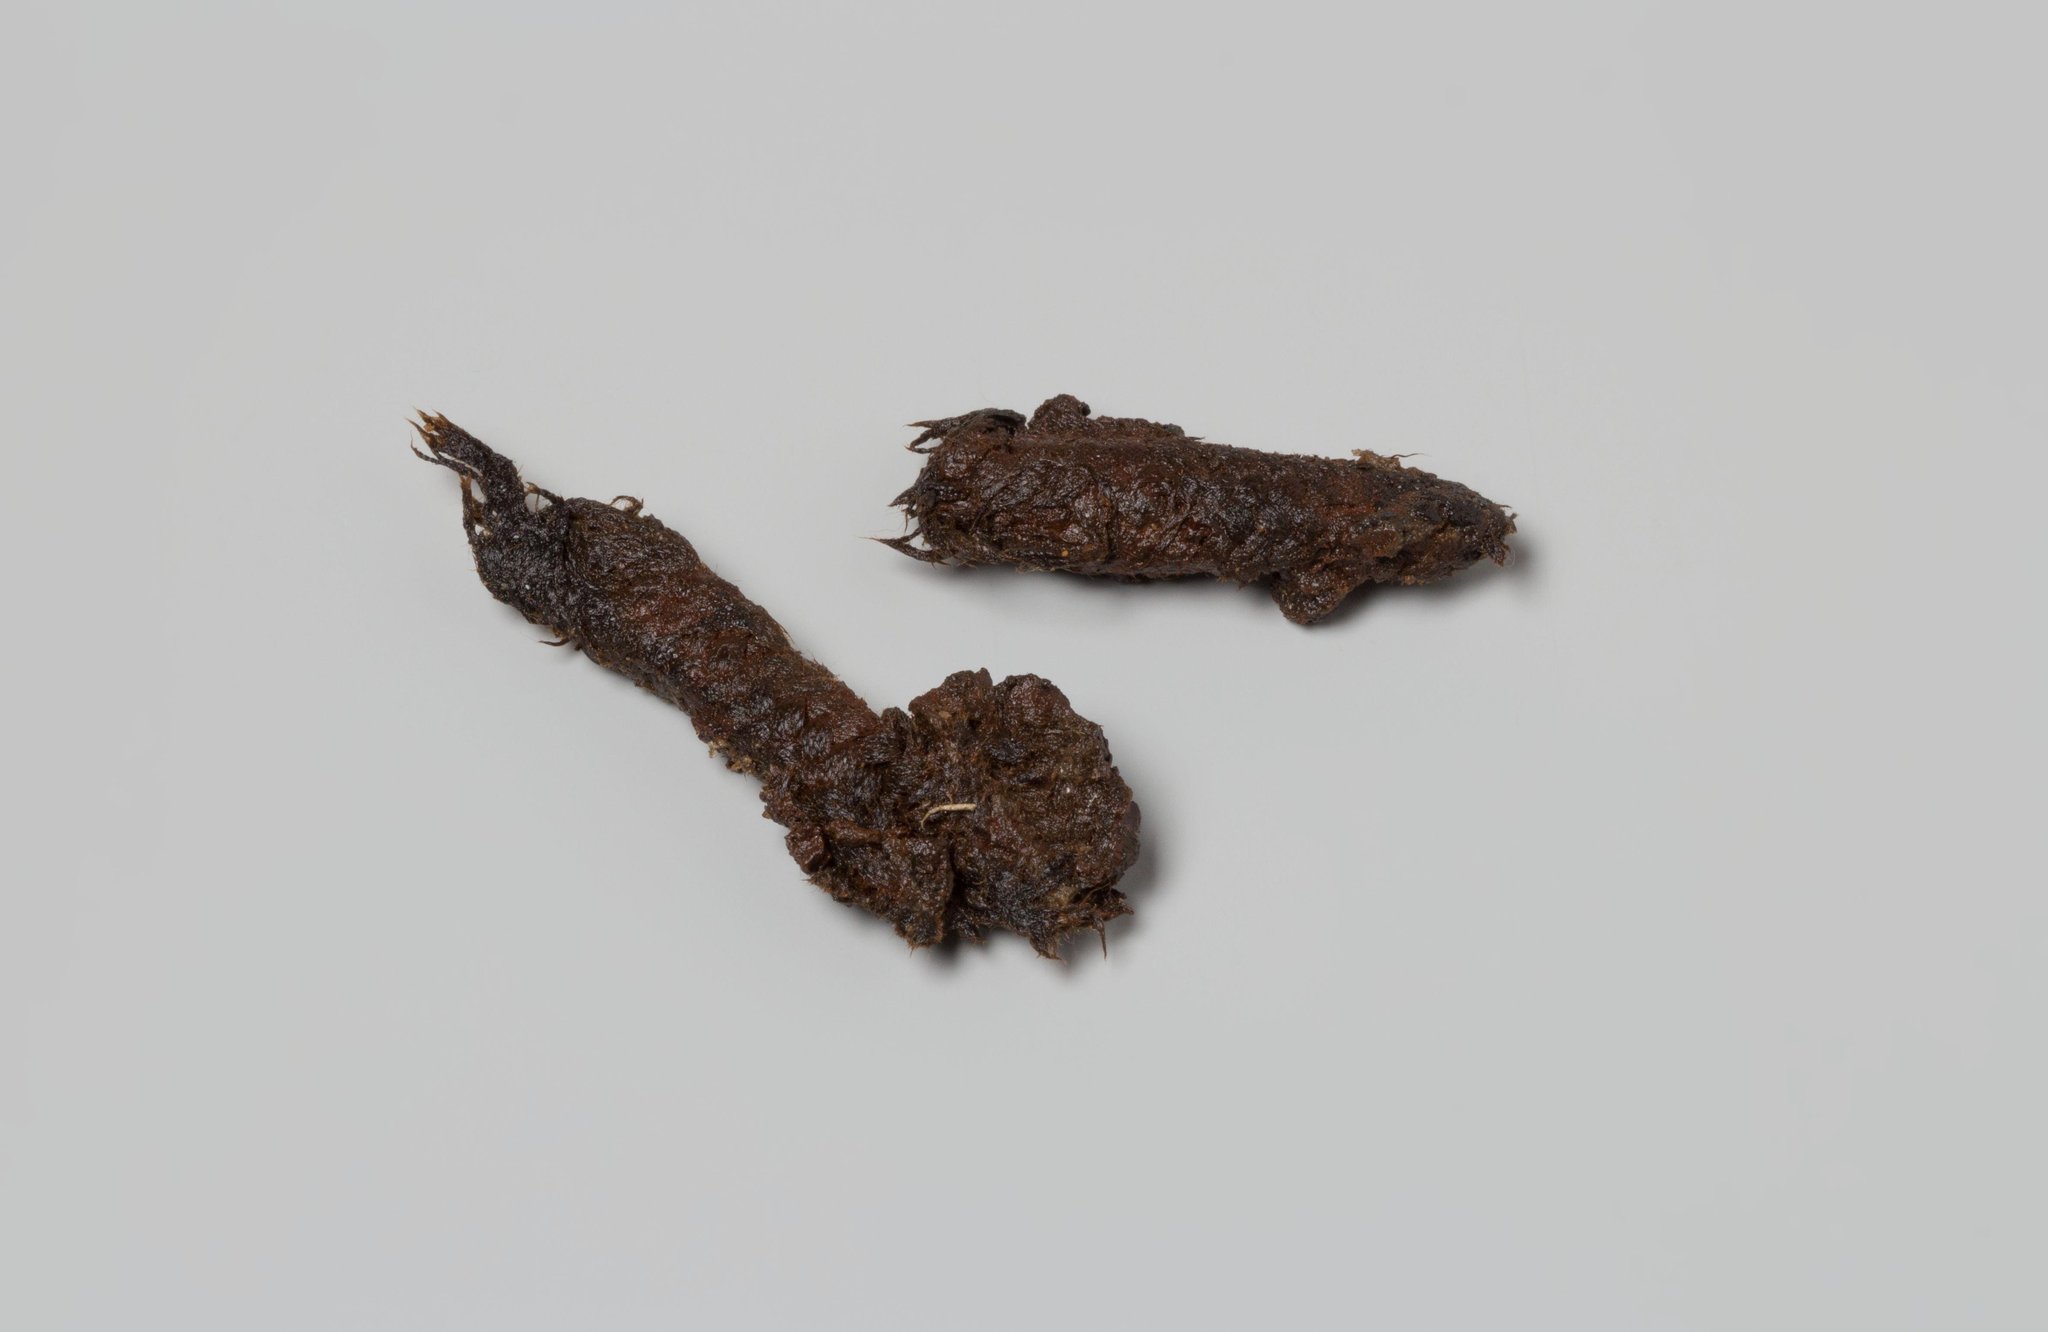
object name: lanyard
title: Fragmenten van een koord uit het wrak van de in 1735 vergane Oost-Indiëvaarder 't Vliegend Hart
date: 1700-1735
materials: textile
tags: 't vliegend hart (schip), verenigde oostindische compagnie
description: De twee stukjes koord zijn bruin verkleurd en gebreid.